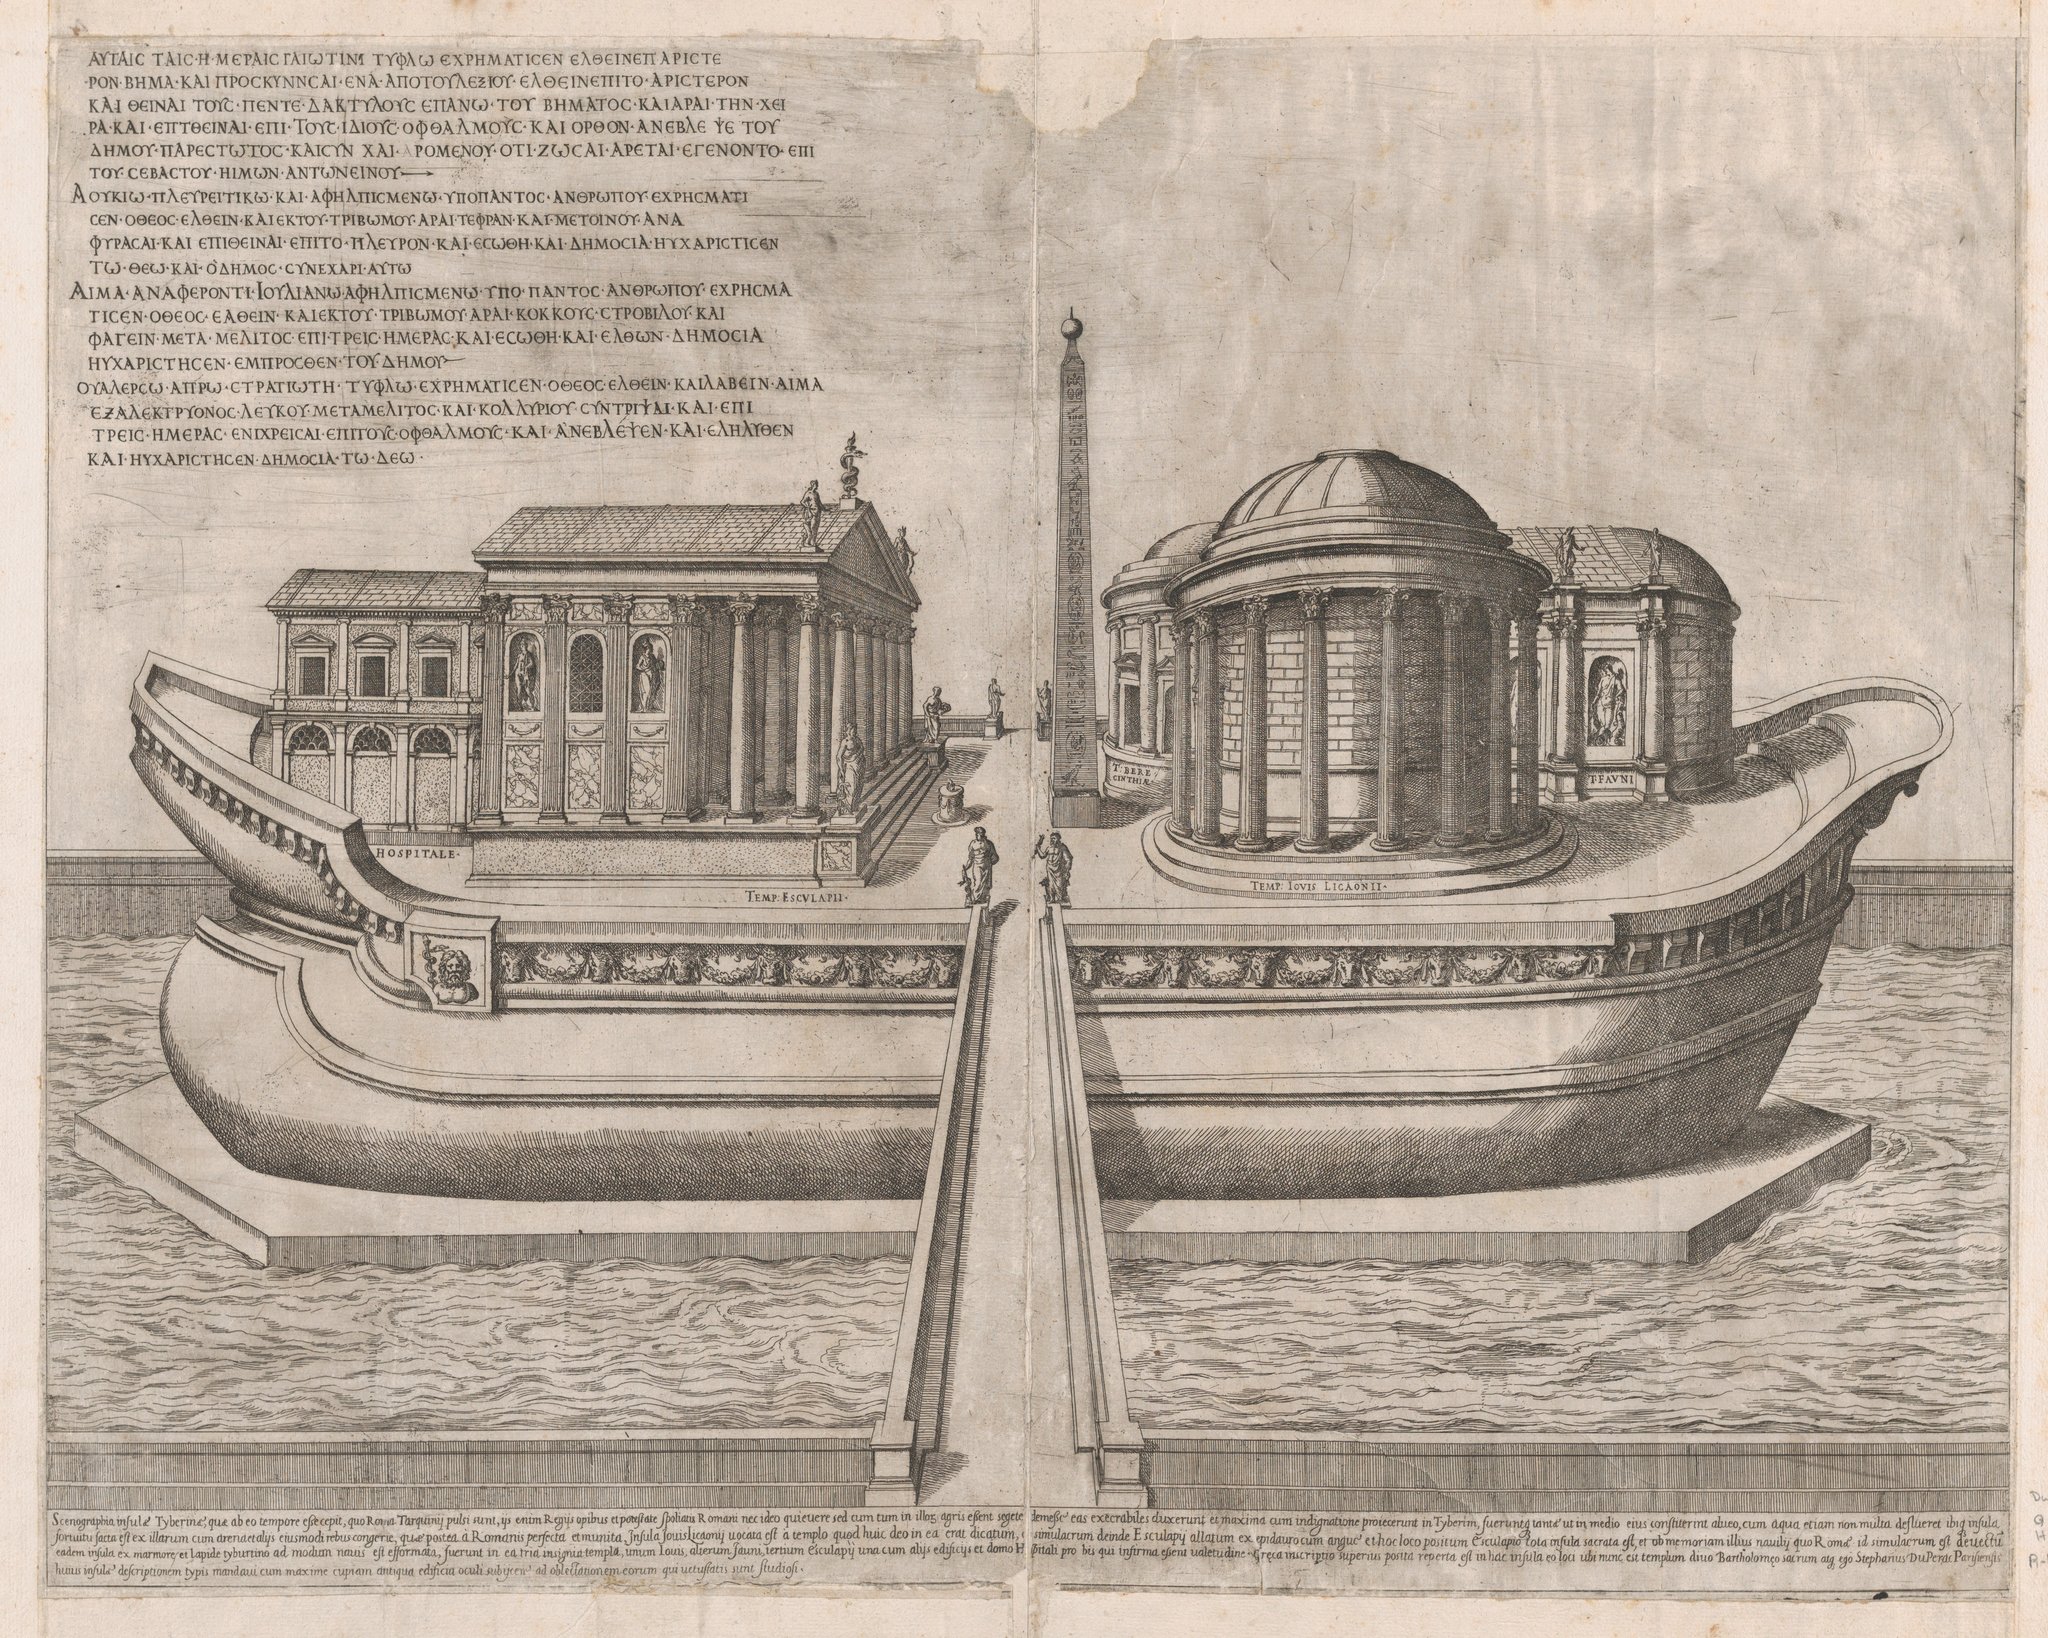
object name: print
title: Temples on the Isle of Tiber, from "Speculum Romanae Magnificentiae"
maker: etienne dupérac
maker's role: artist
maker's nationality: french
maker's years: 1535-1604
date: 1582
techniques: engraving, etching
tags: temples